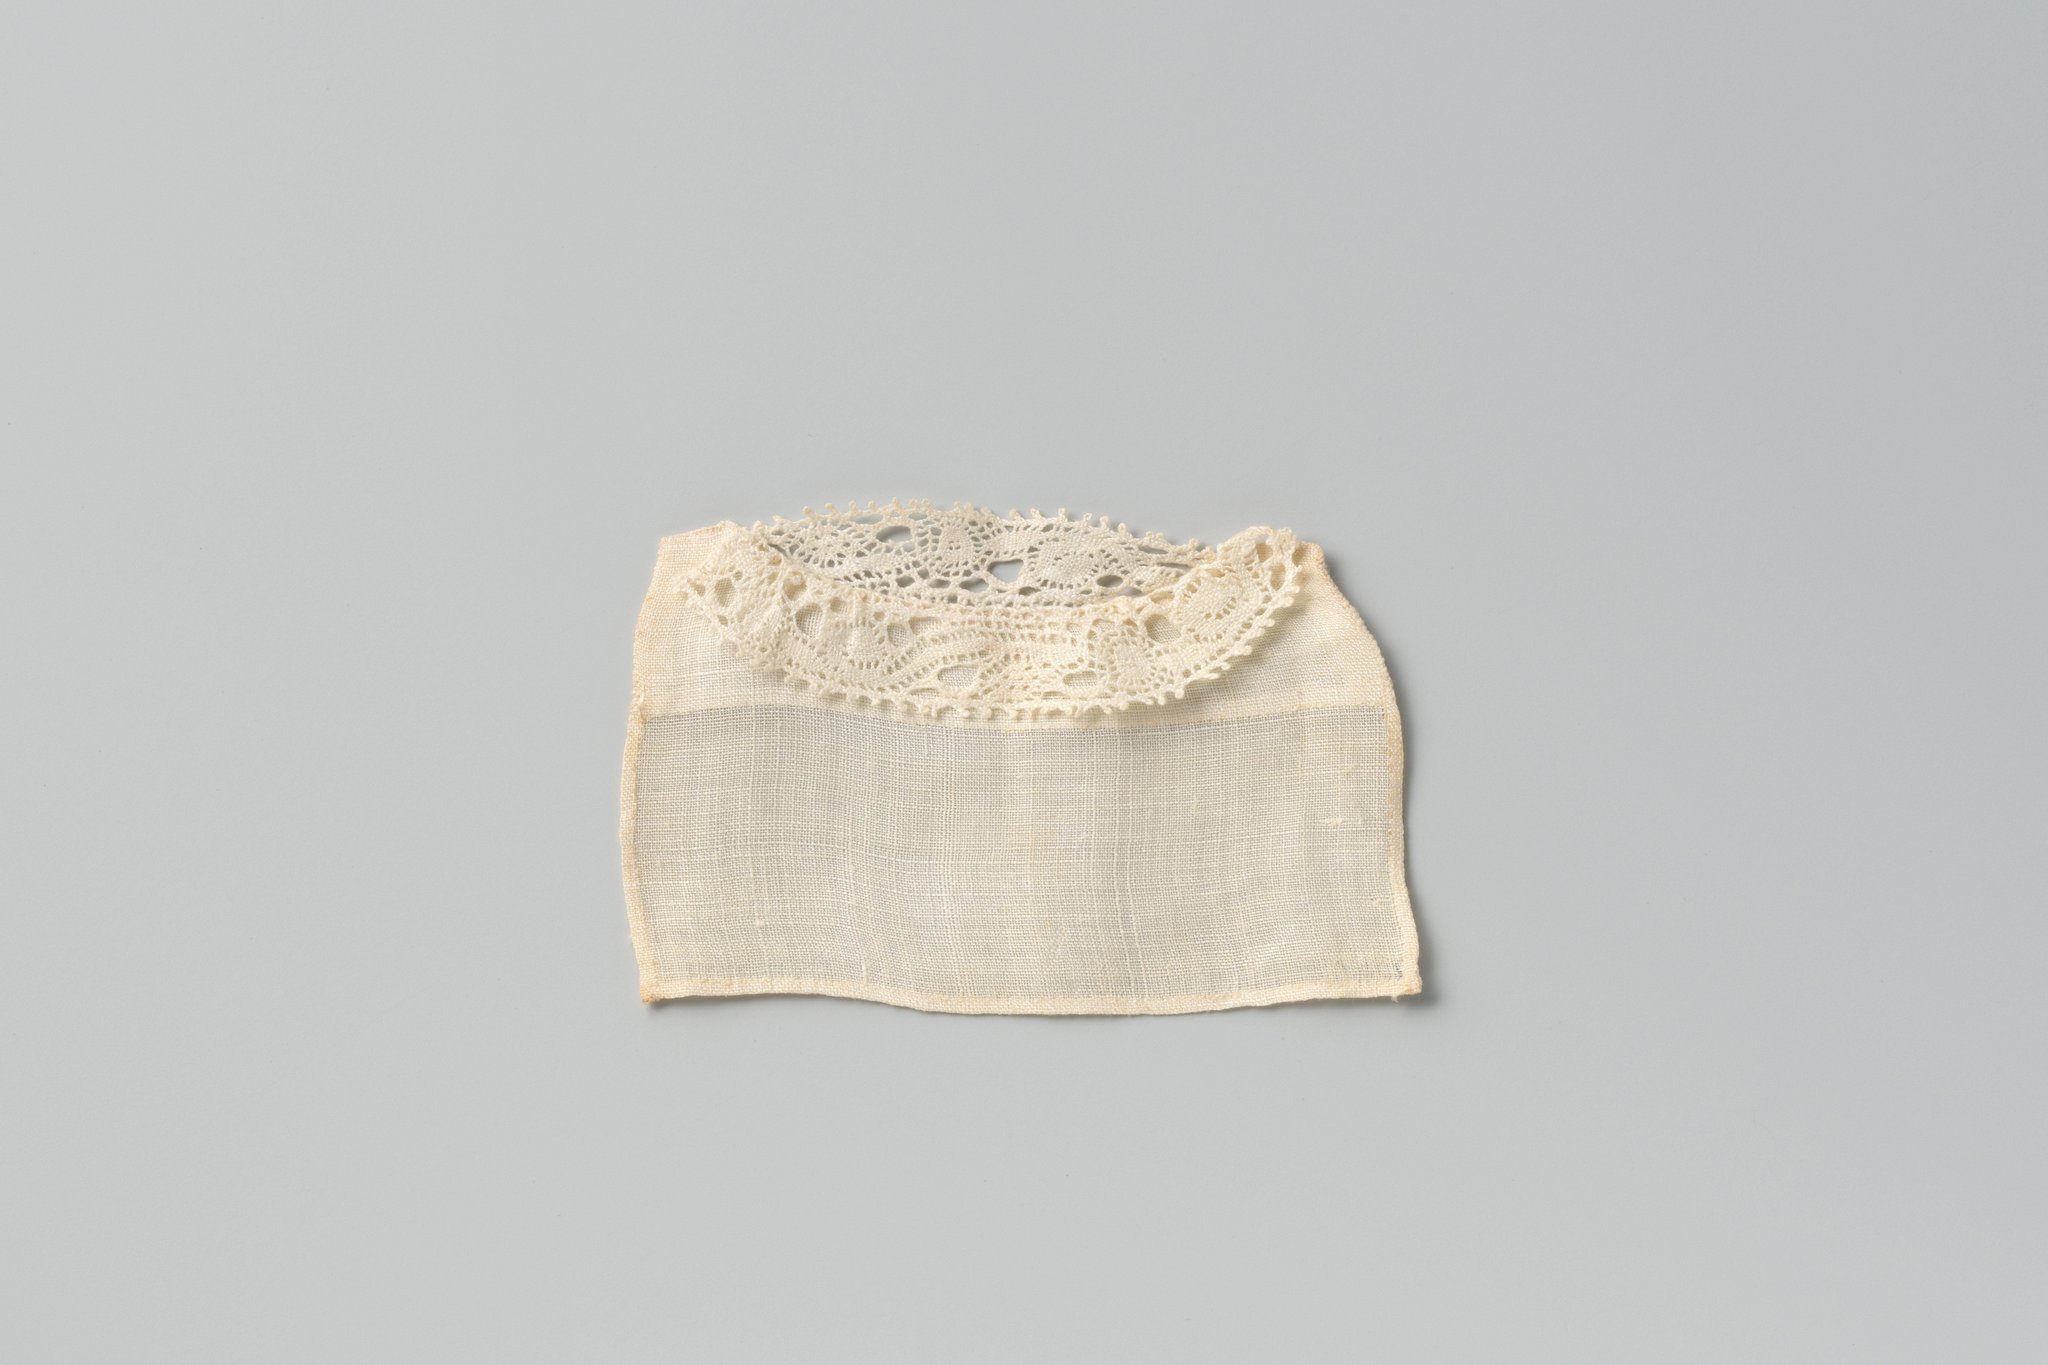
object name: band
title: Bef van linnen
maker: Anonymous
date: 1676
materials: linen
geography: amsterdam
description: Bef van linnen, aan drie zijden omzoomd en aan één zijde iets hol afgezet met een naar beneden omgeslagen strook kant en een tweede strook kant, waarvan de zijkanten wegvallen.